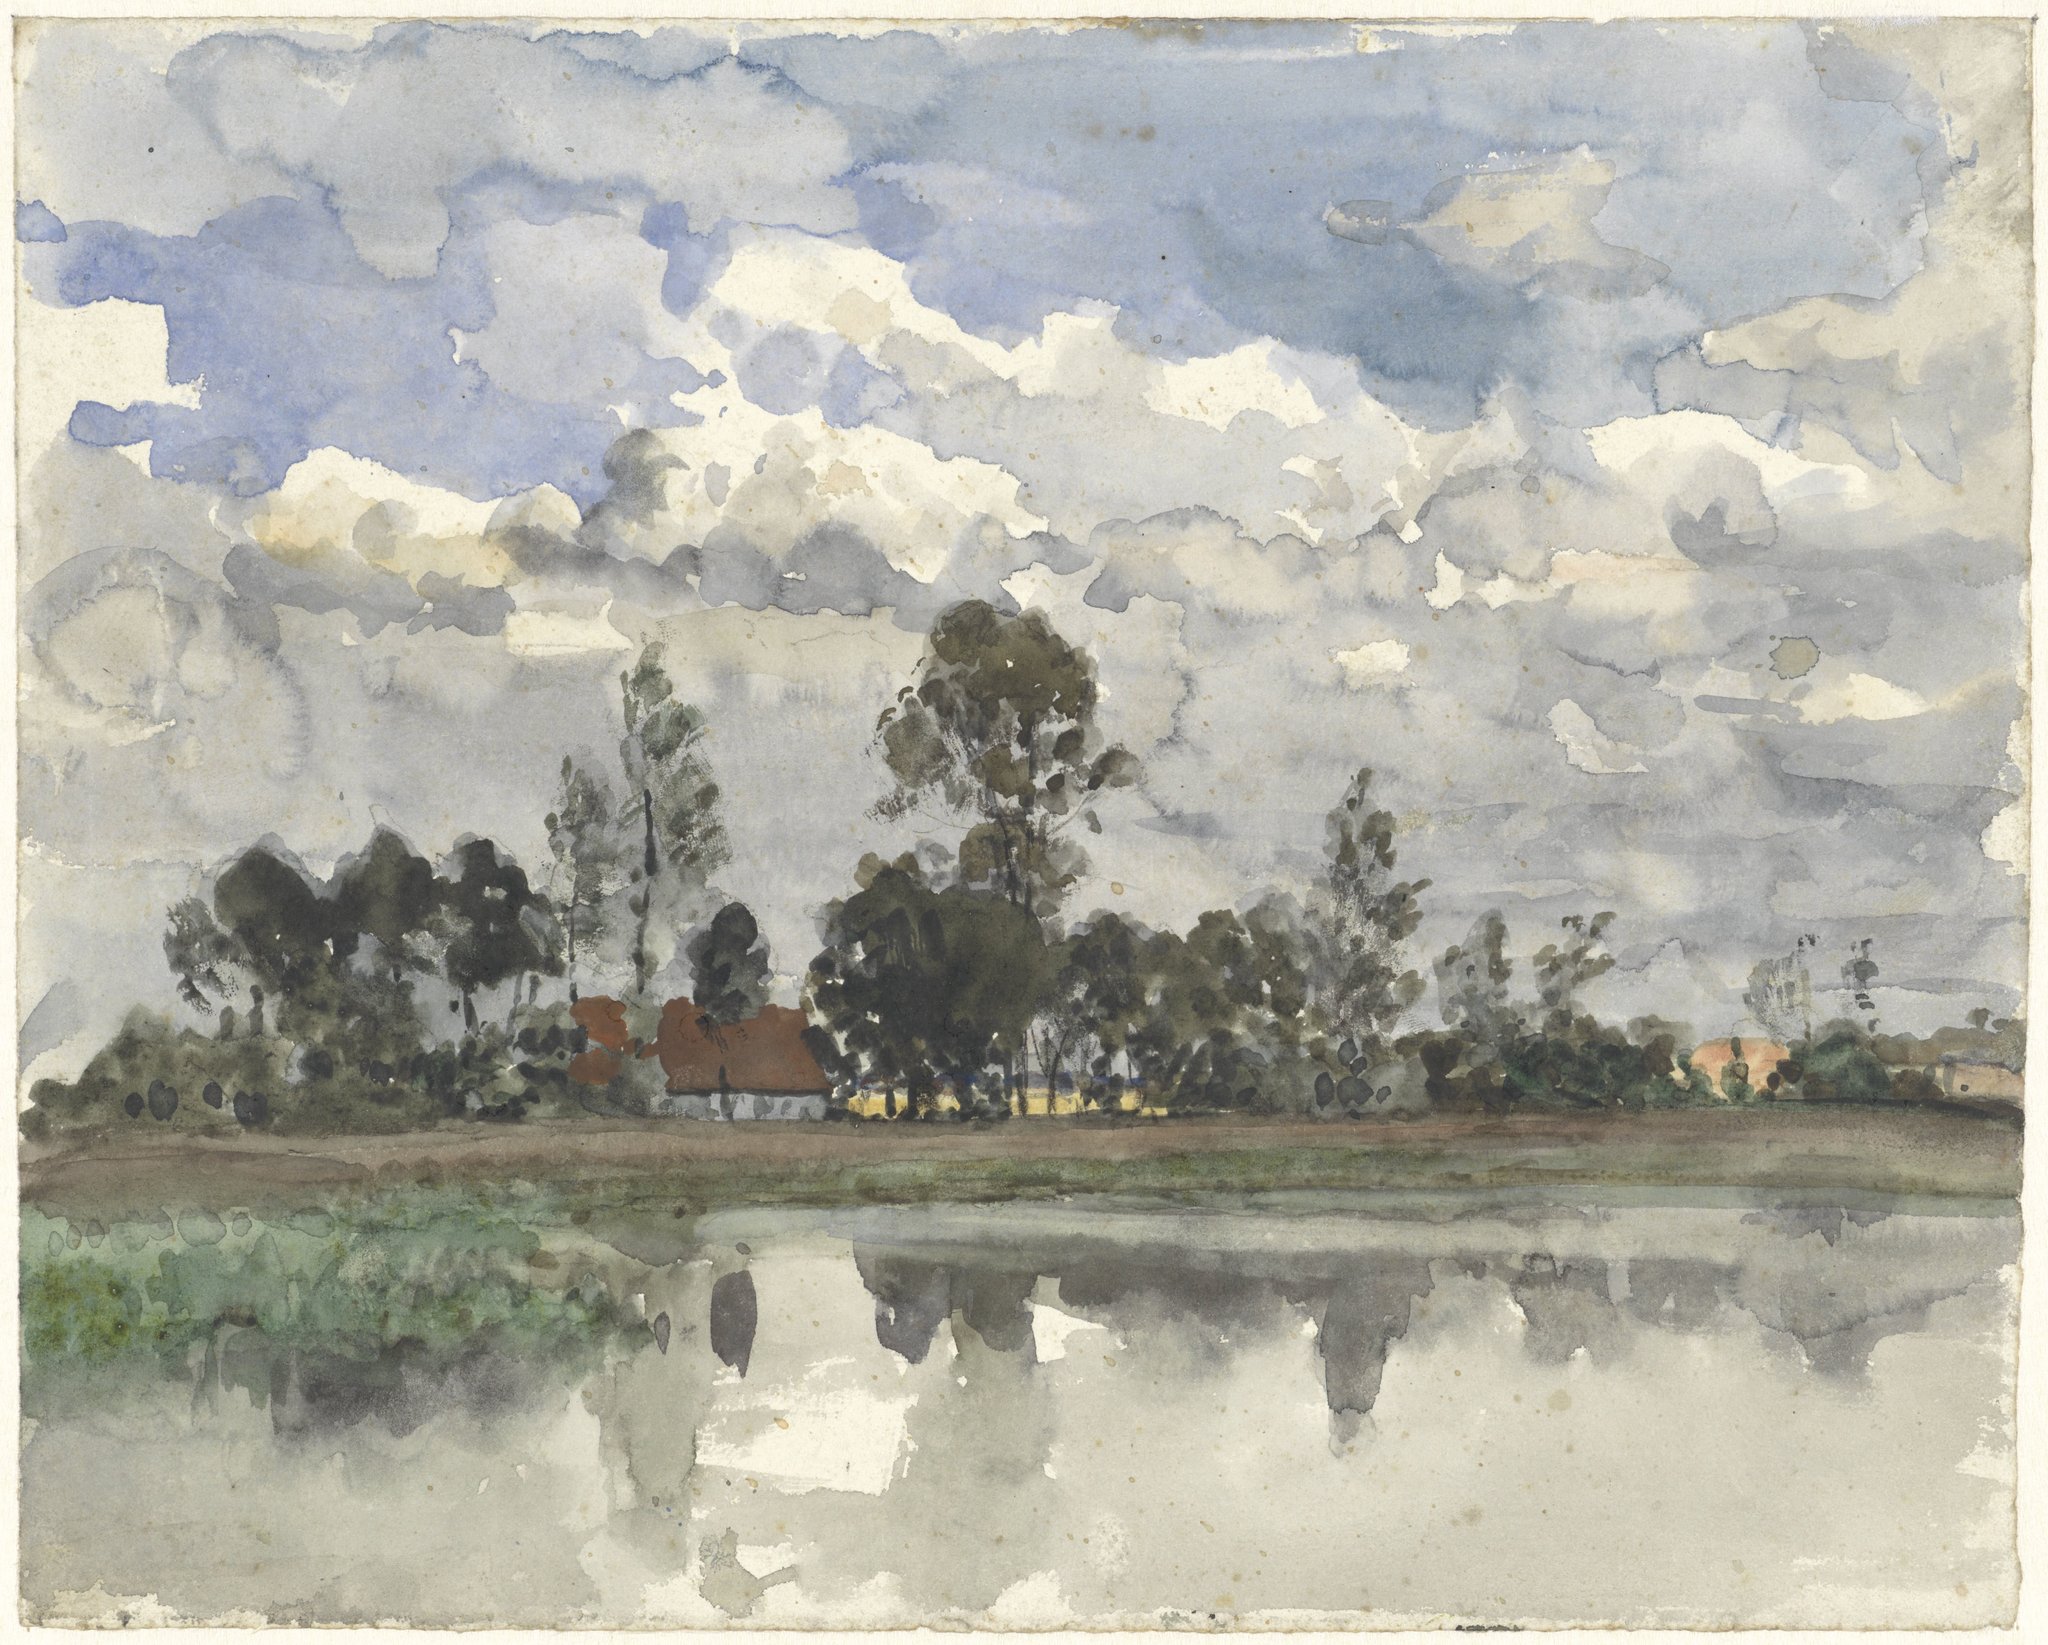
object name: drawing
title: Bomen zich spiegelend in het water bij een bewolkte lucht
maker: julius jacobus van de sande bakhuyzen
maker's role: draughtsman, painter, print maker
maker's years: 1835-1925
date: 1845-1925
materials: chalk, paper, watercolor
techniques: brush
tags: small canal, ditch, farm or solitary house in landscape